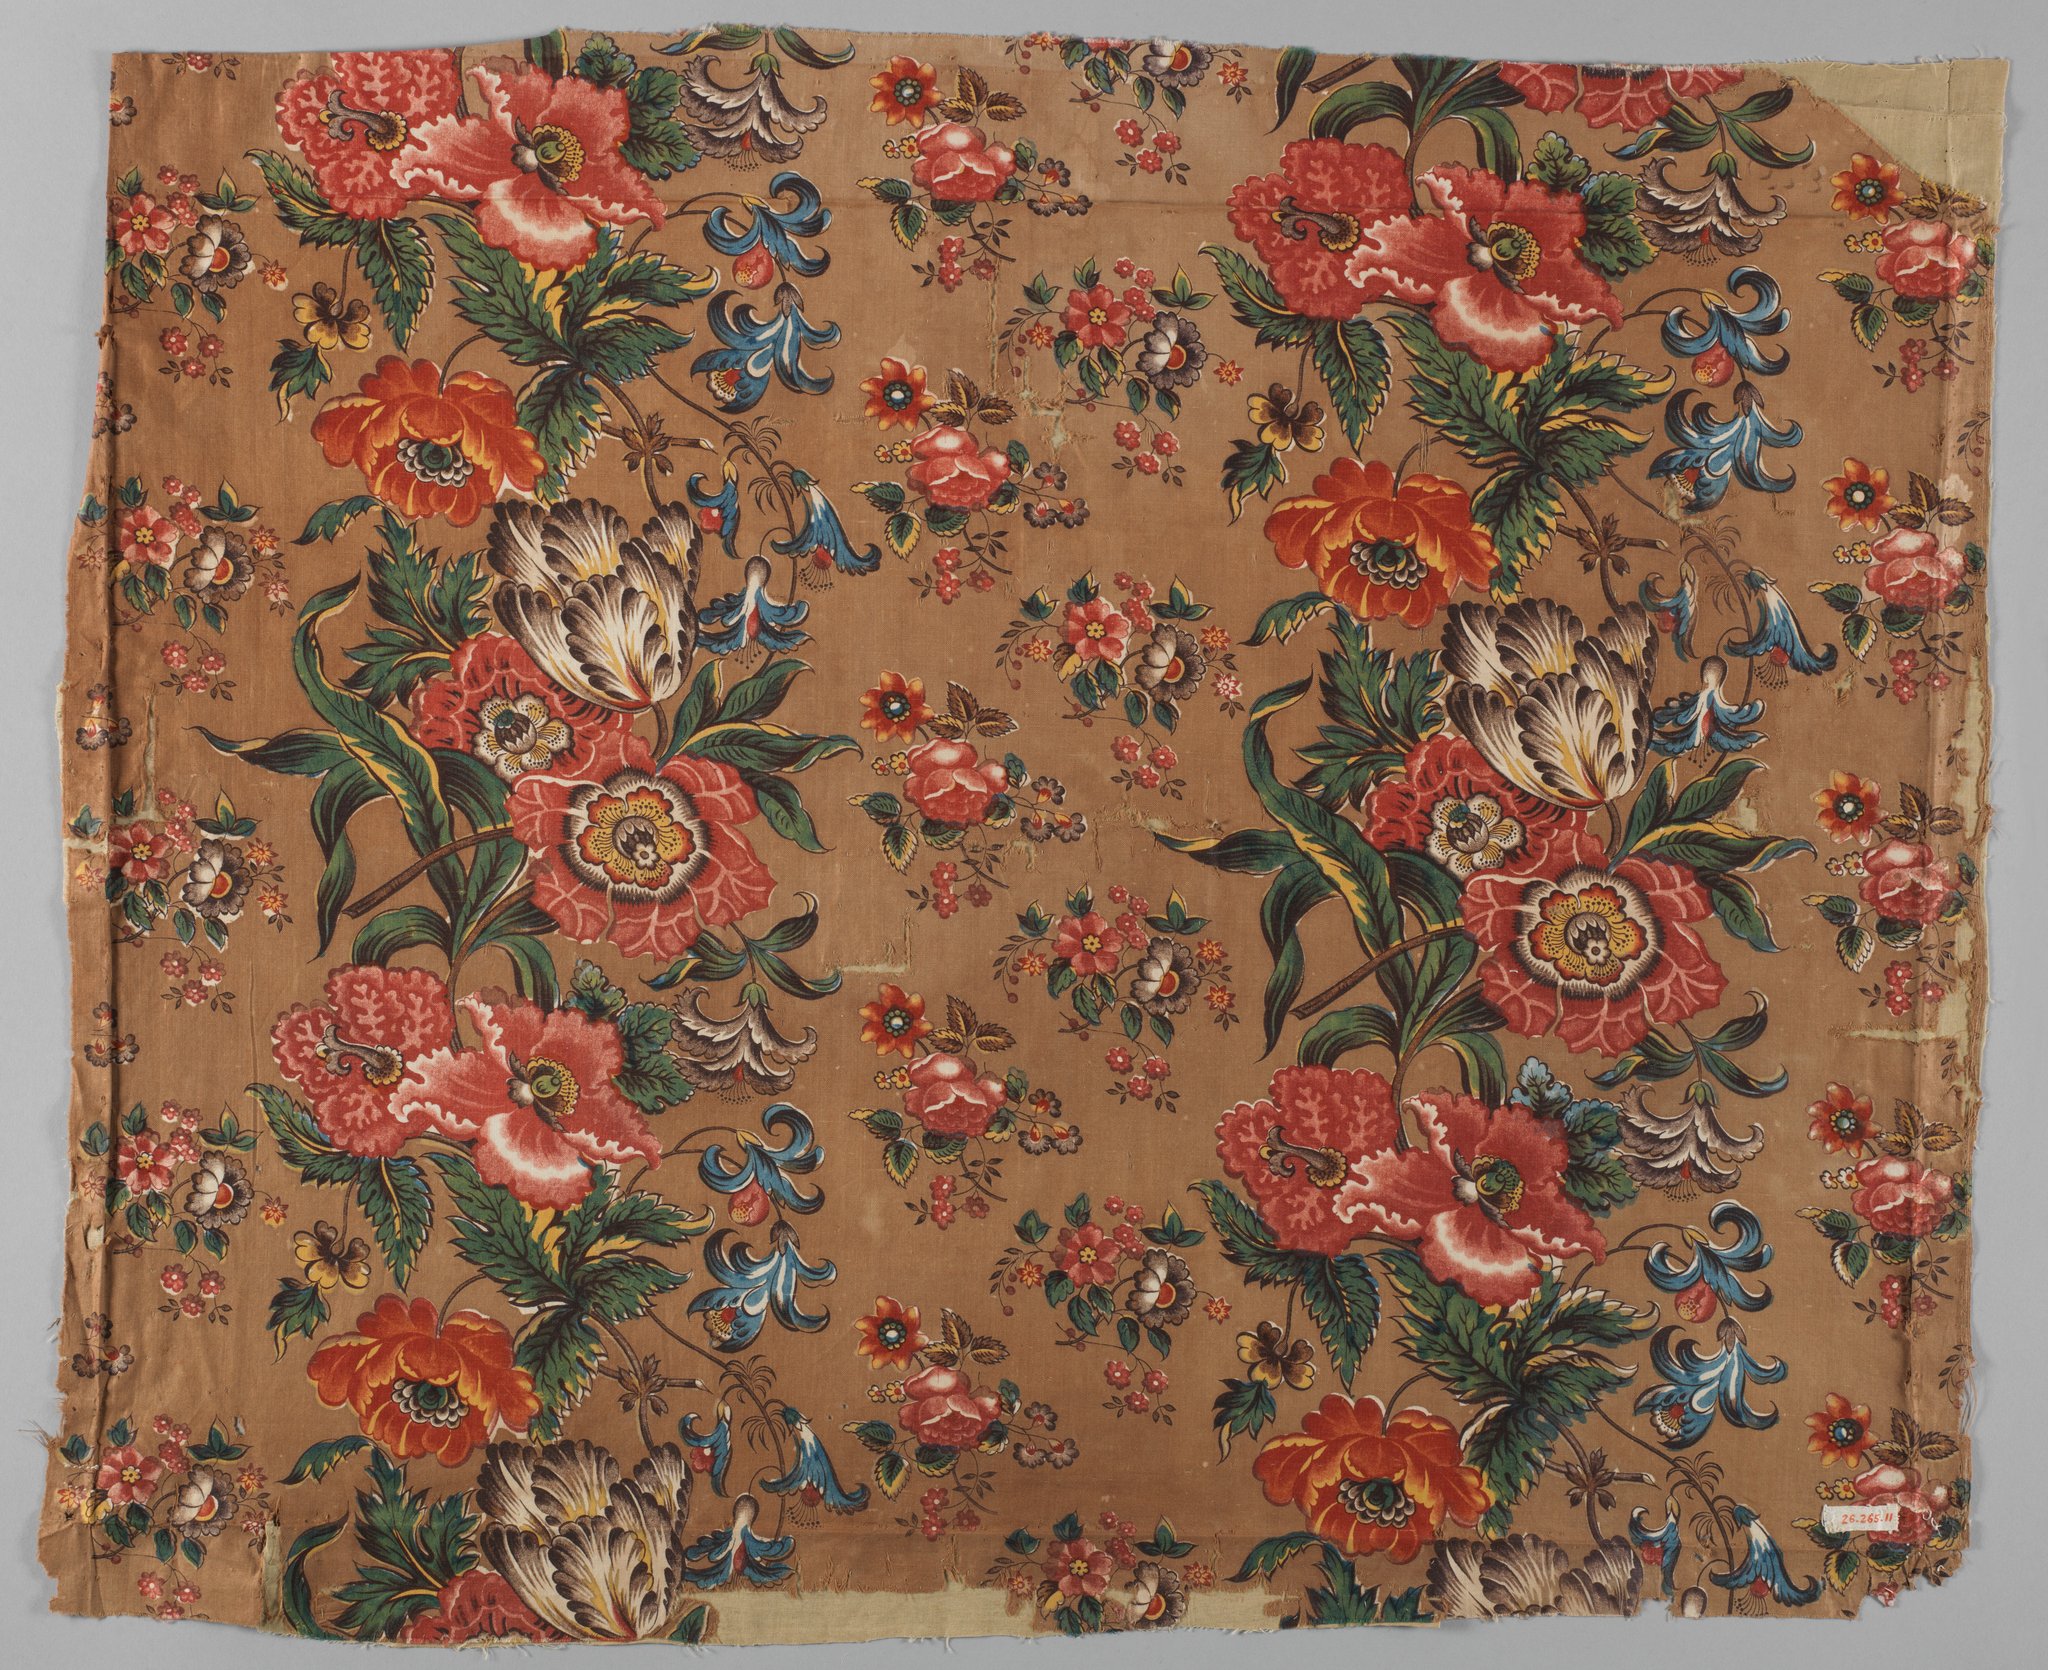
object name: piece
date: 1835-1840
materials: cotton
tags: flowers